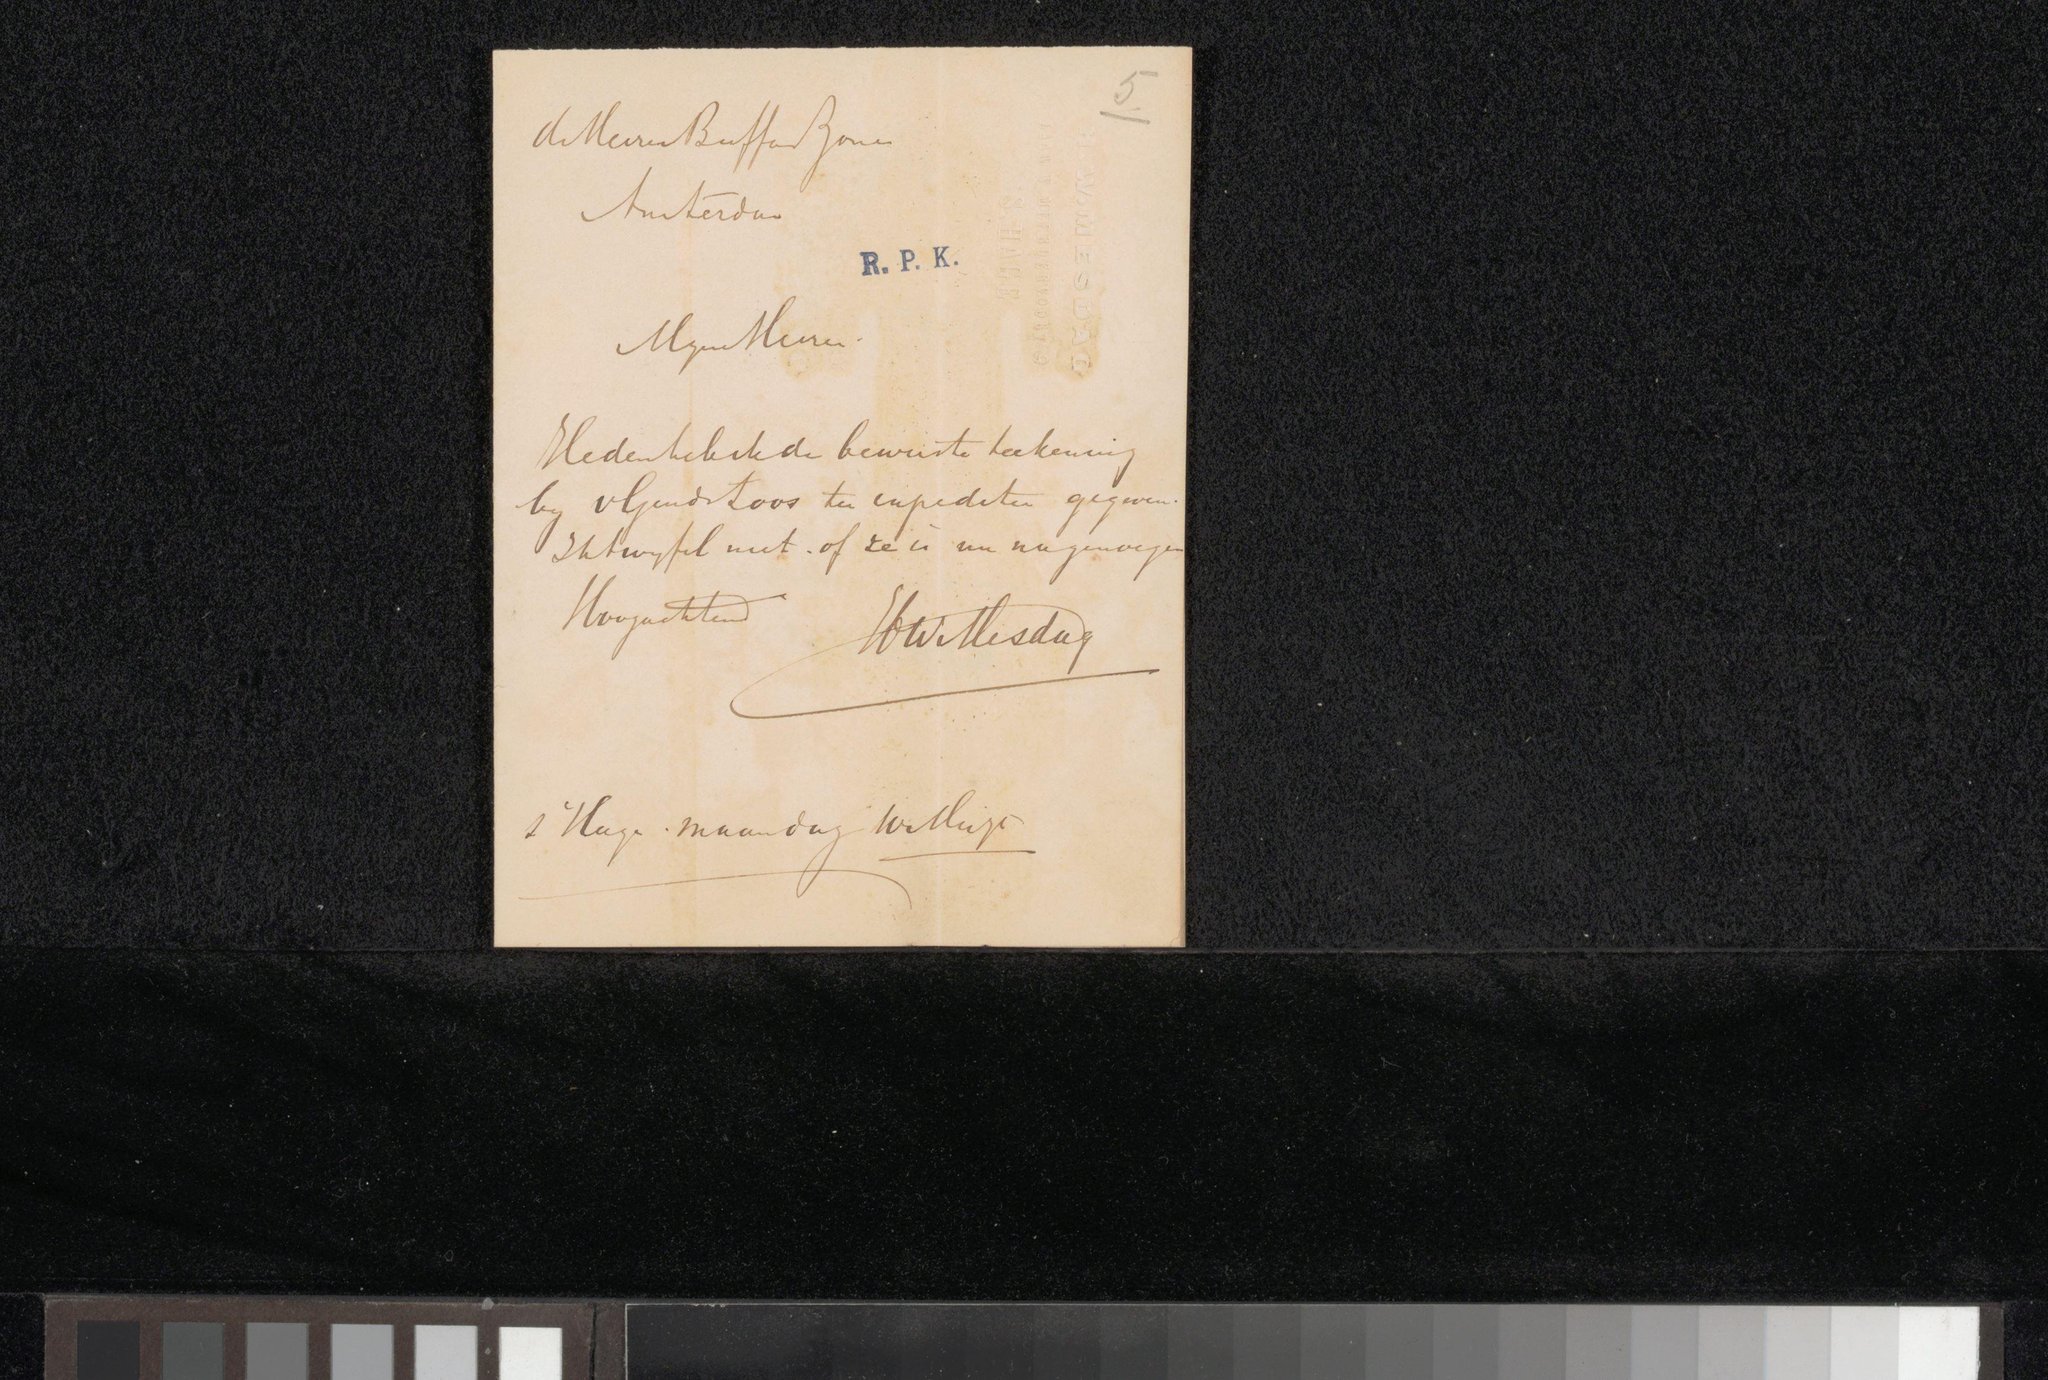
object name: letter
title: Brief aan Frans Buffa en Zonen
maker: hendrik willem mesdag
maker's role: draughtsman, painter, print maker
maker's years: 1831-1915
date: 1875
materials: ink, paper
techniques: pen, writing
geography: the hague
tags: publisher, drawing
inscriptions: name: ‘H.W. MESDAG/ LAAN V MEERDERVOORT 9/ 'S,HAGE’, collector's mark: Lugt 2233